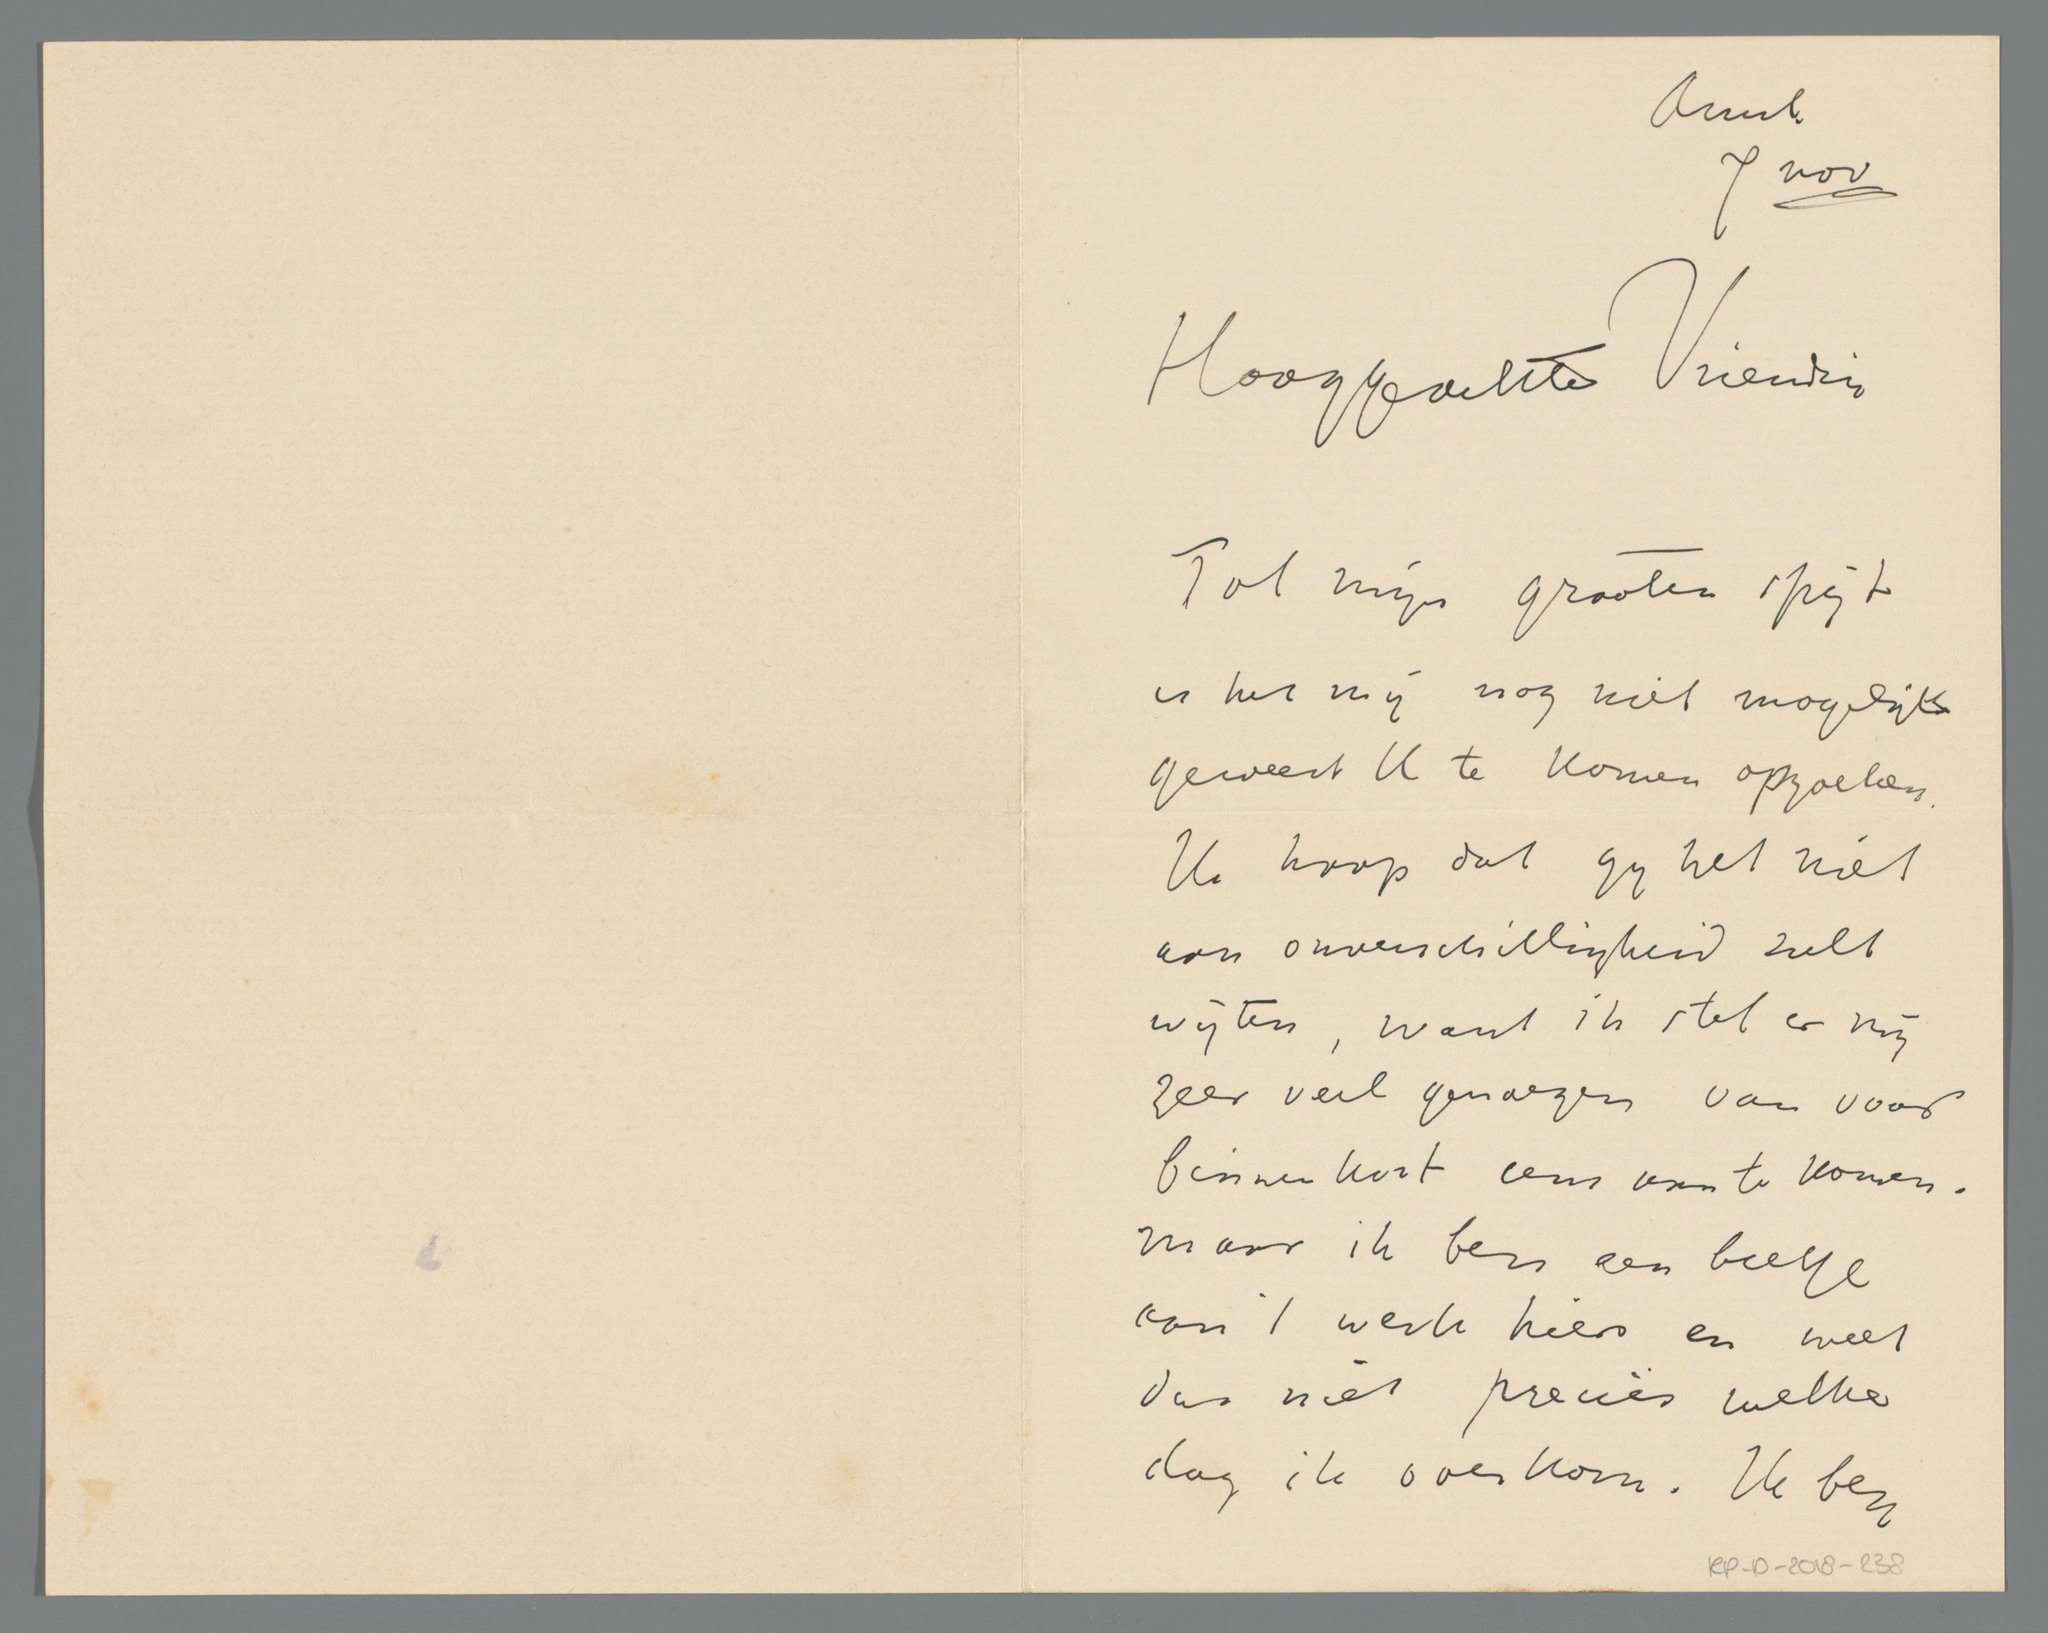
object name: letter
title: Brief aan Jeannette Bouman-Stuyling de Lange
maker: isaac israels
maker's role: draughtsman, painter, print maker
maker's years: 1865-1934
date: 1898-1919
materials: ink, paper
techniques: pen, writing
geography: amsterdam